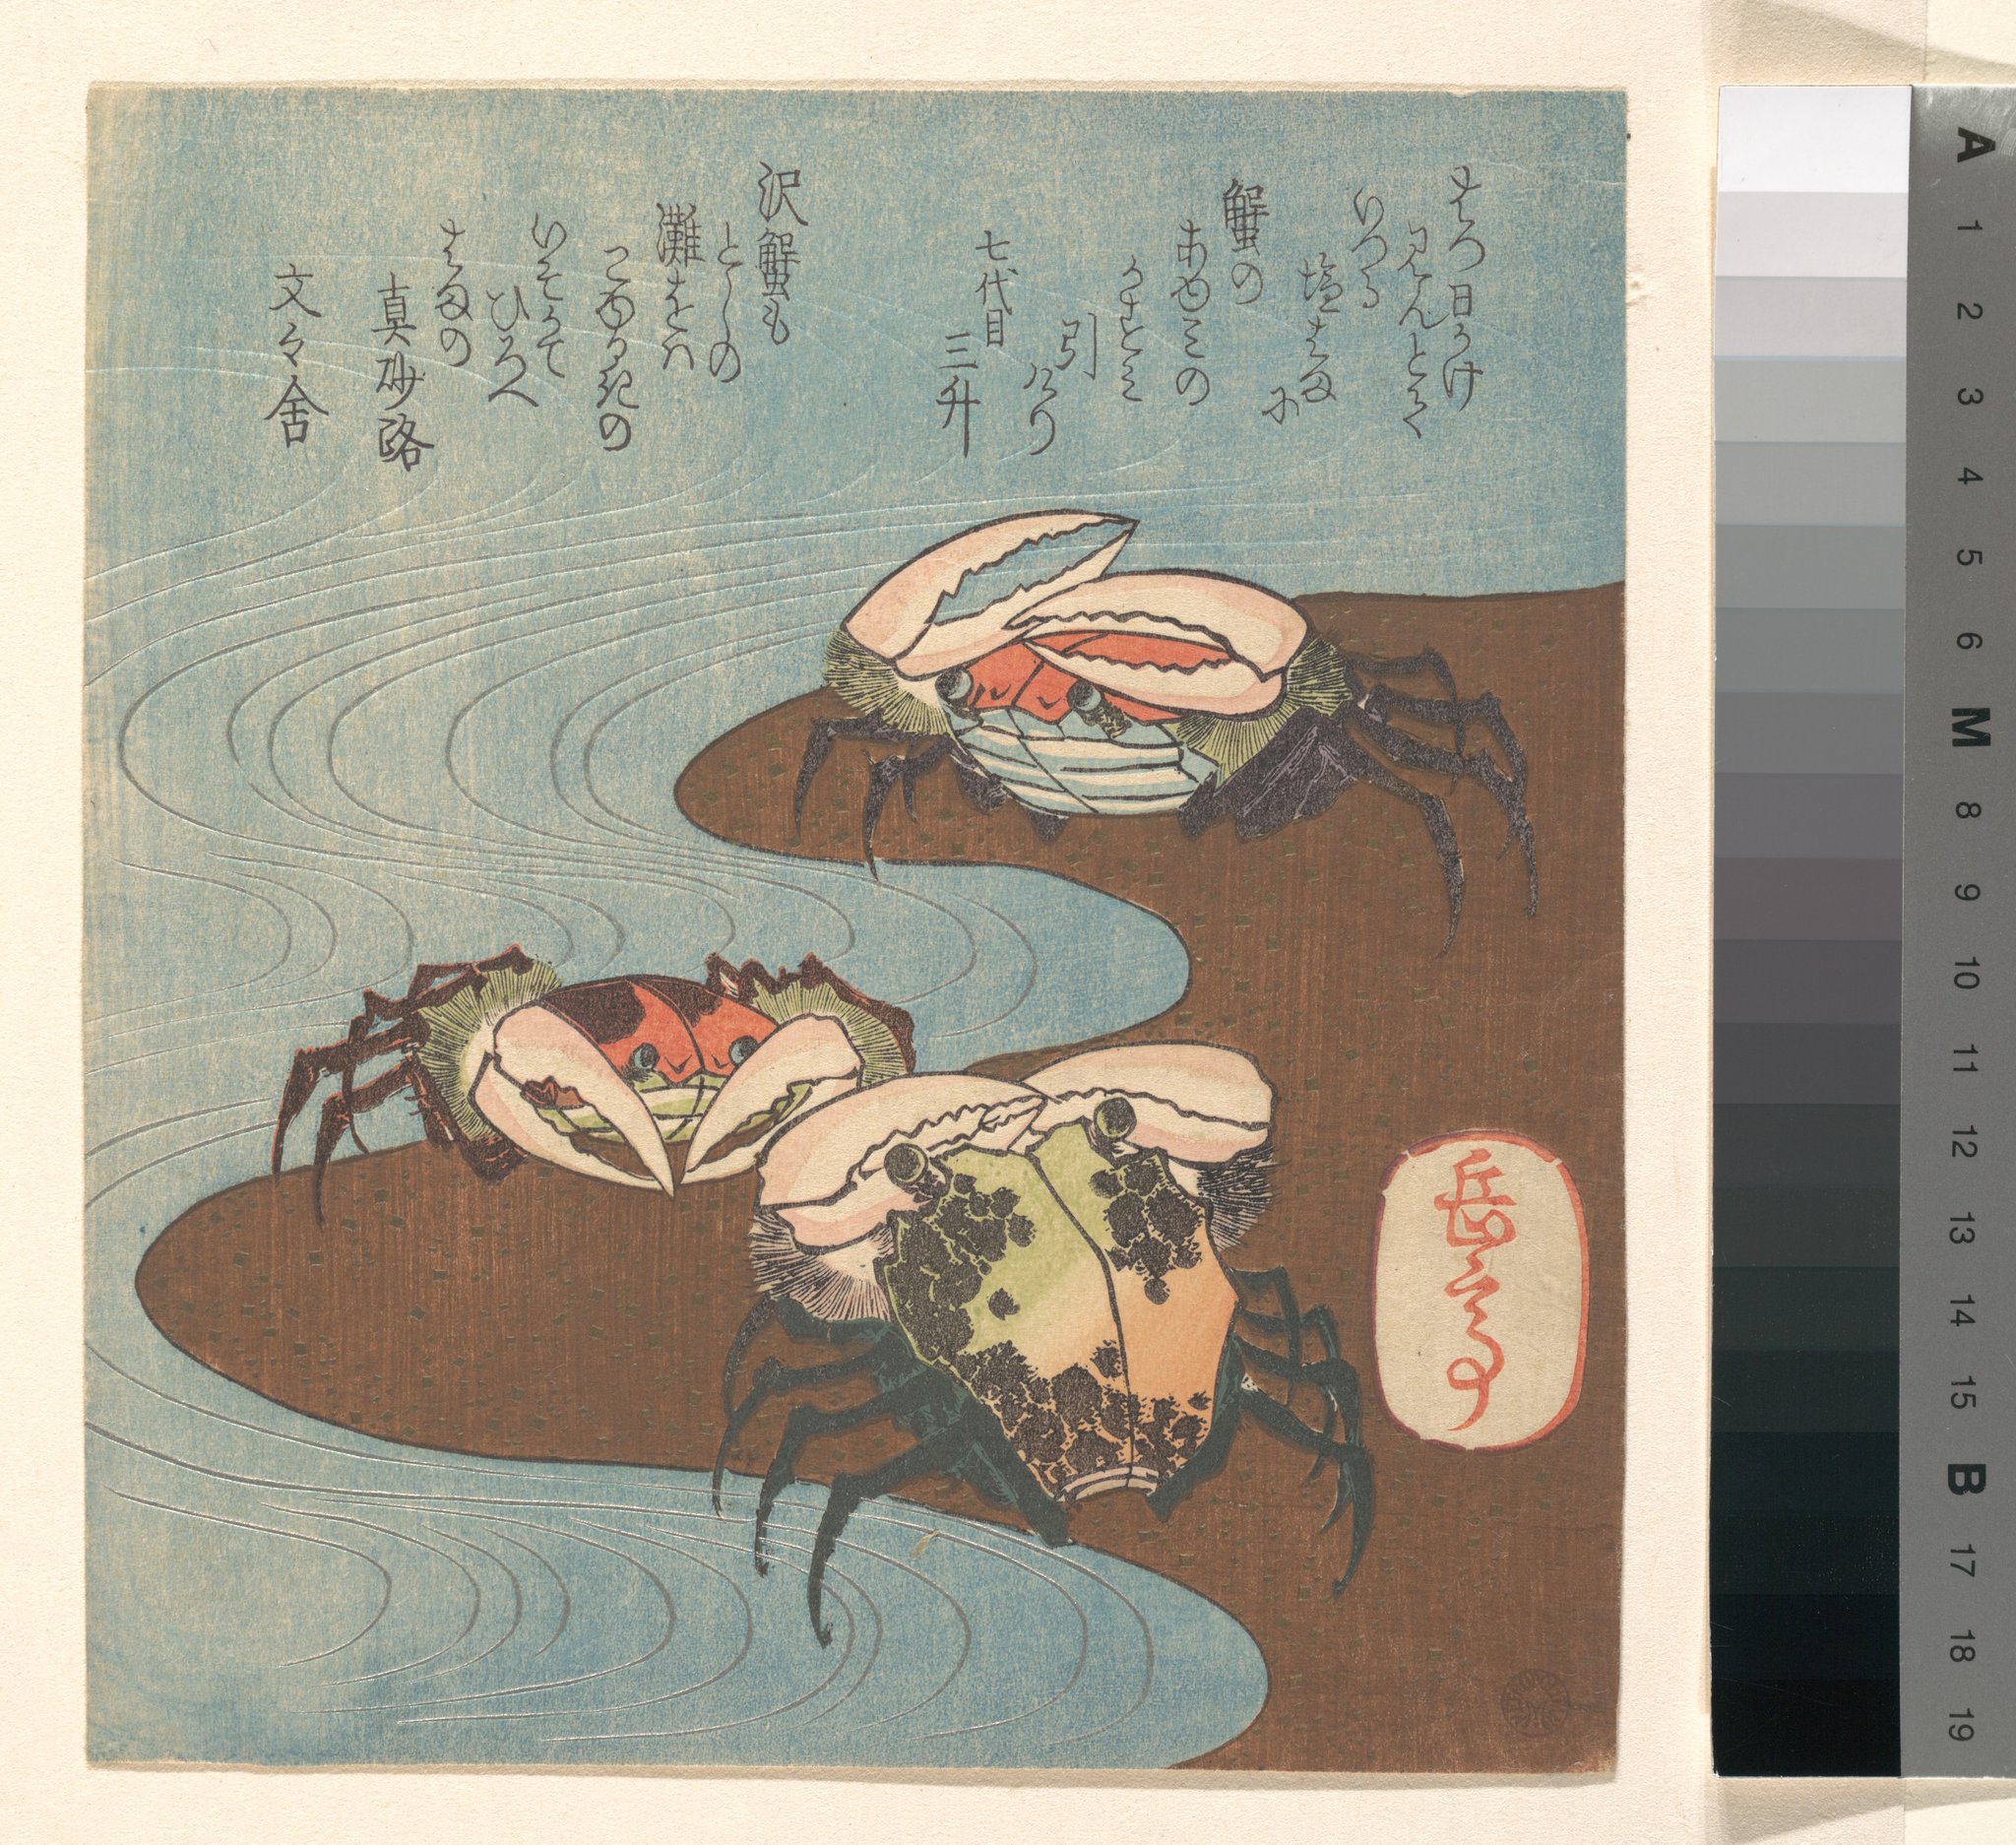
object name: print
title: Crabs Near the Water's Edge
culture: japanese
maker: yashima gakutei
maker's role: artist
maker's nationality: japanese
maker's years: 1786-1868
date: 1830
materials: ink, paper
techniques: surimono, woodblock print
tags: crabs